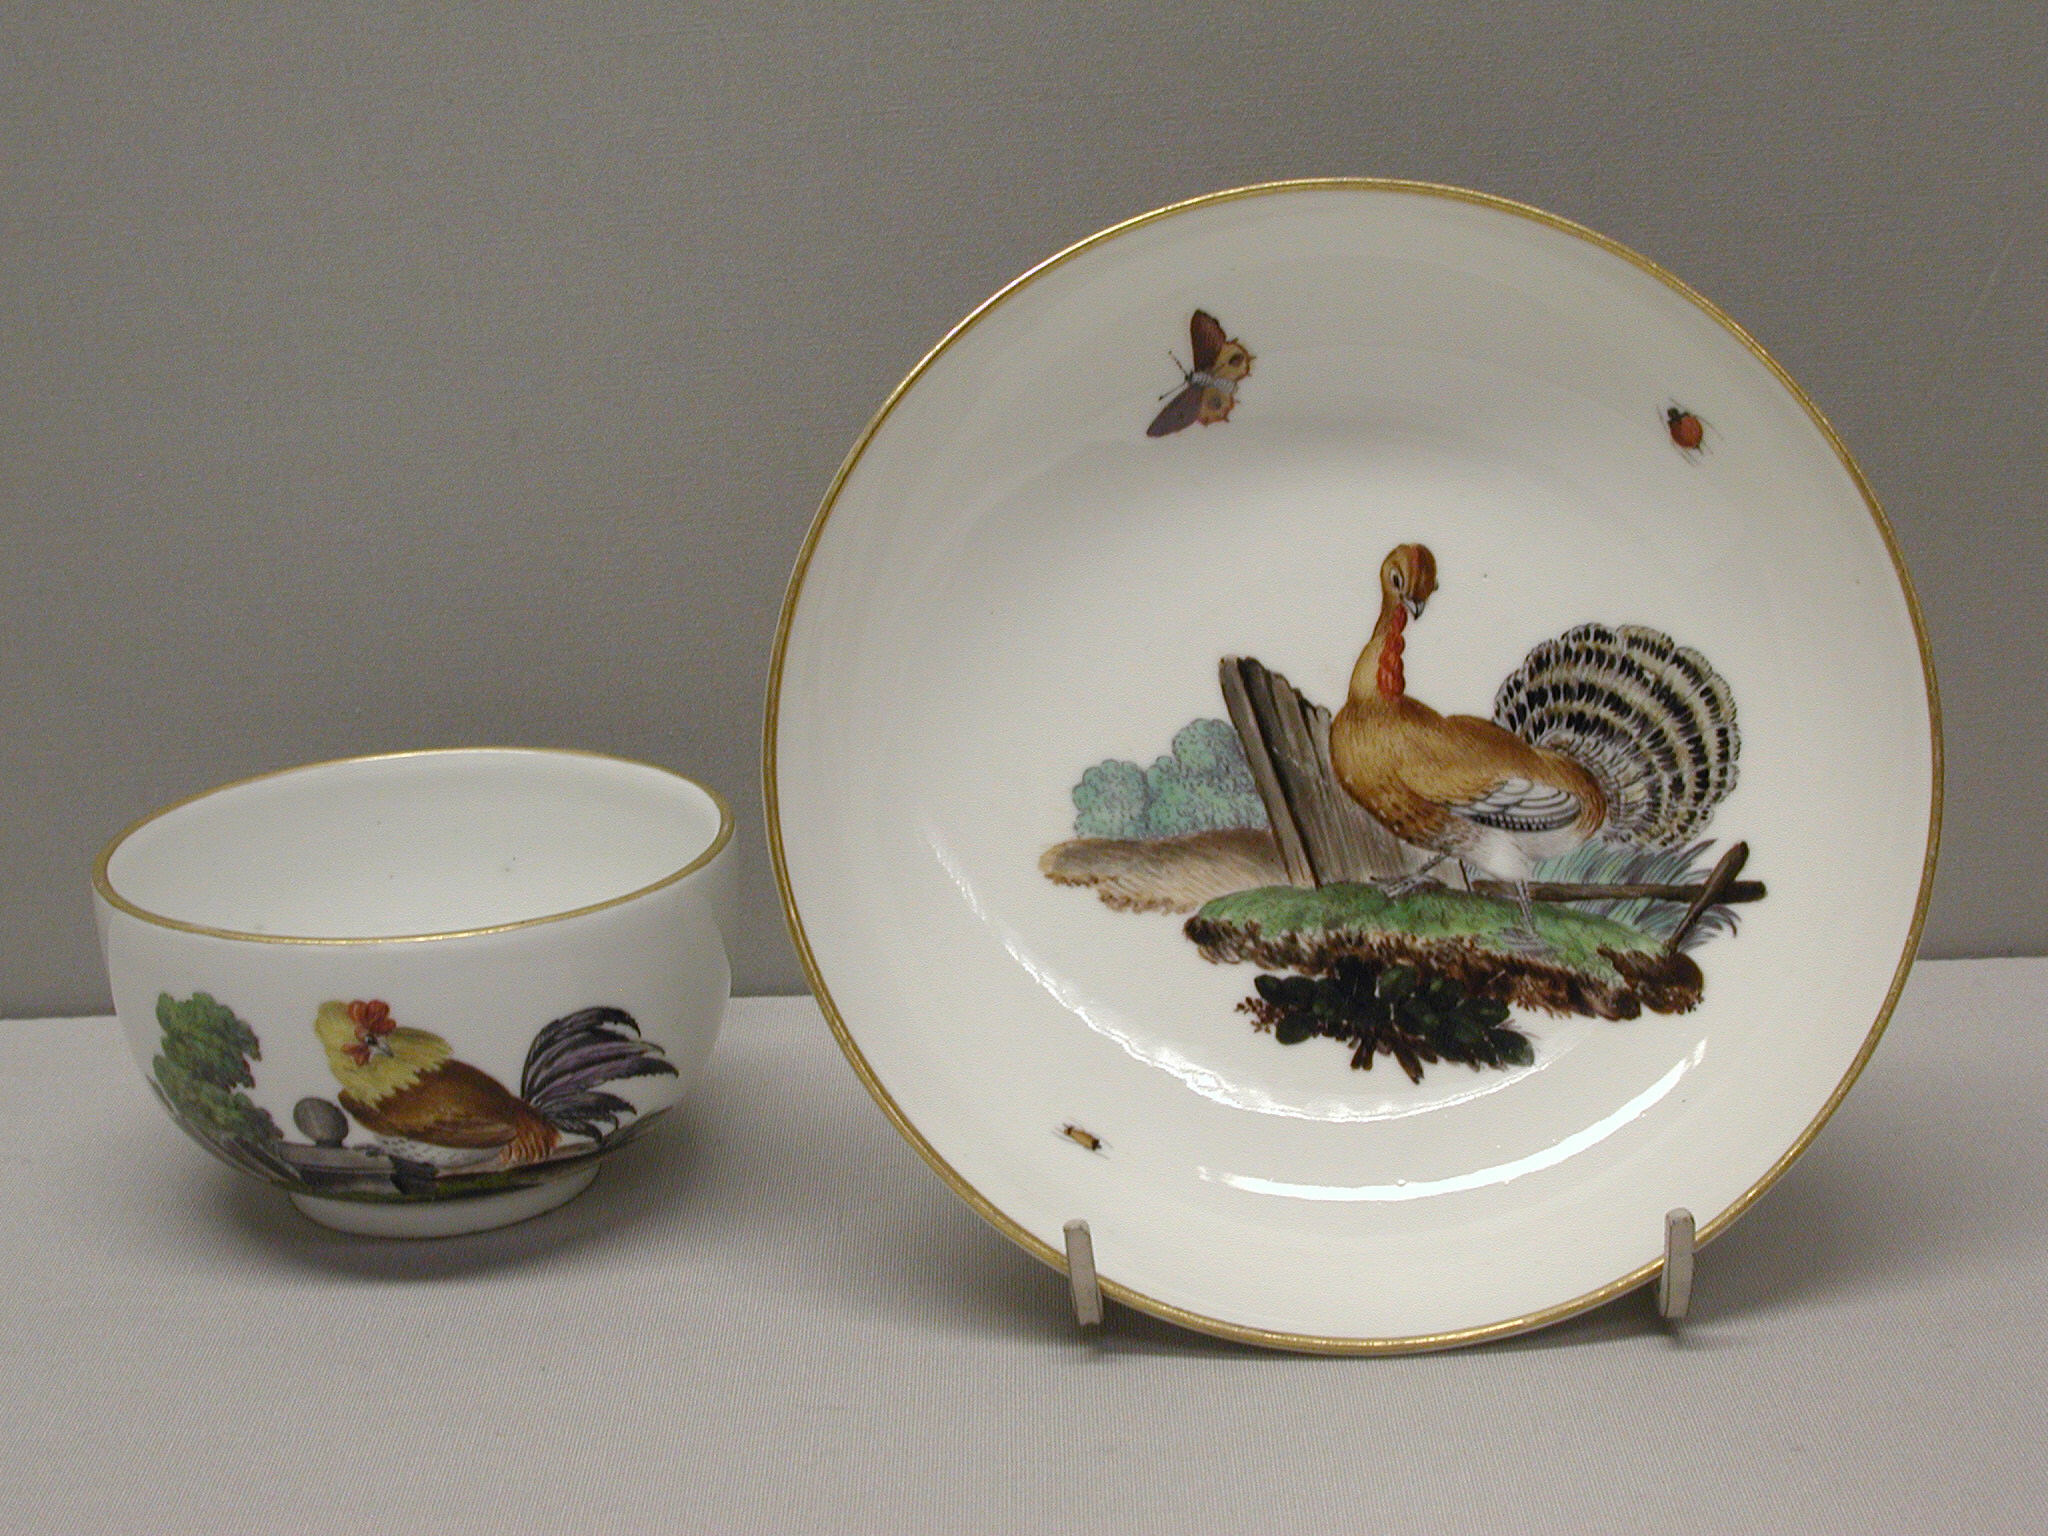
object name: teacup and saucer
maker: höchst manufactory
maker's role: manufactory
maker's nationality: german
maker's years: 1746-1796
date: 1775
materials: hard paste porcelain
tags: birds,roosters,butterflies